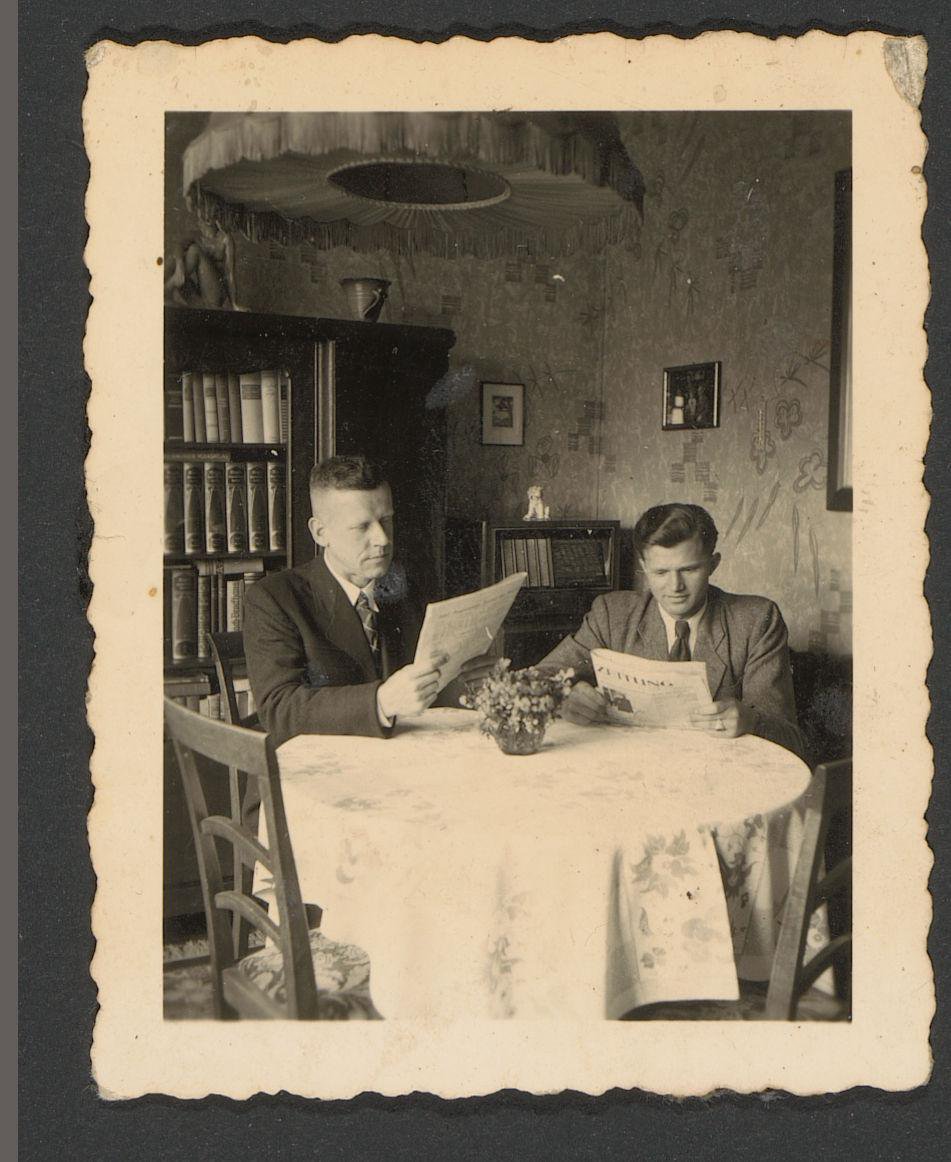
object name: album leaf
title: Twee lezende mannen aan tafel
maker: Anonymous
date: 1930-1945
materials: paper, photographic support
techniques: gelatin silver print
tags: reading, adult man, historical persons, table